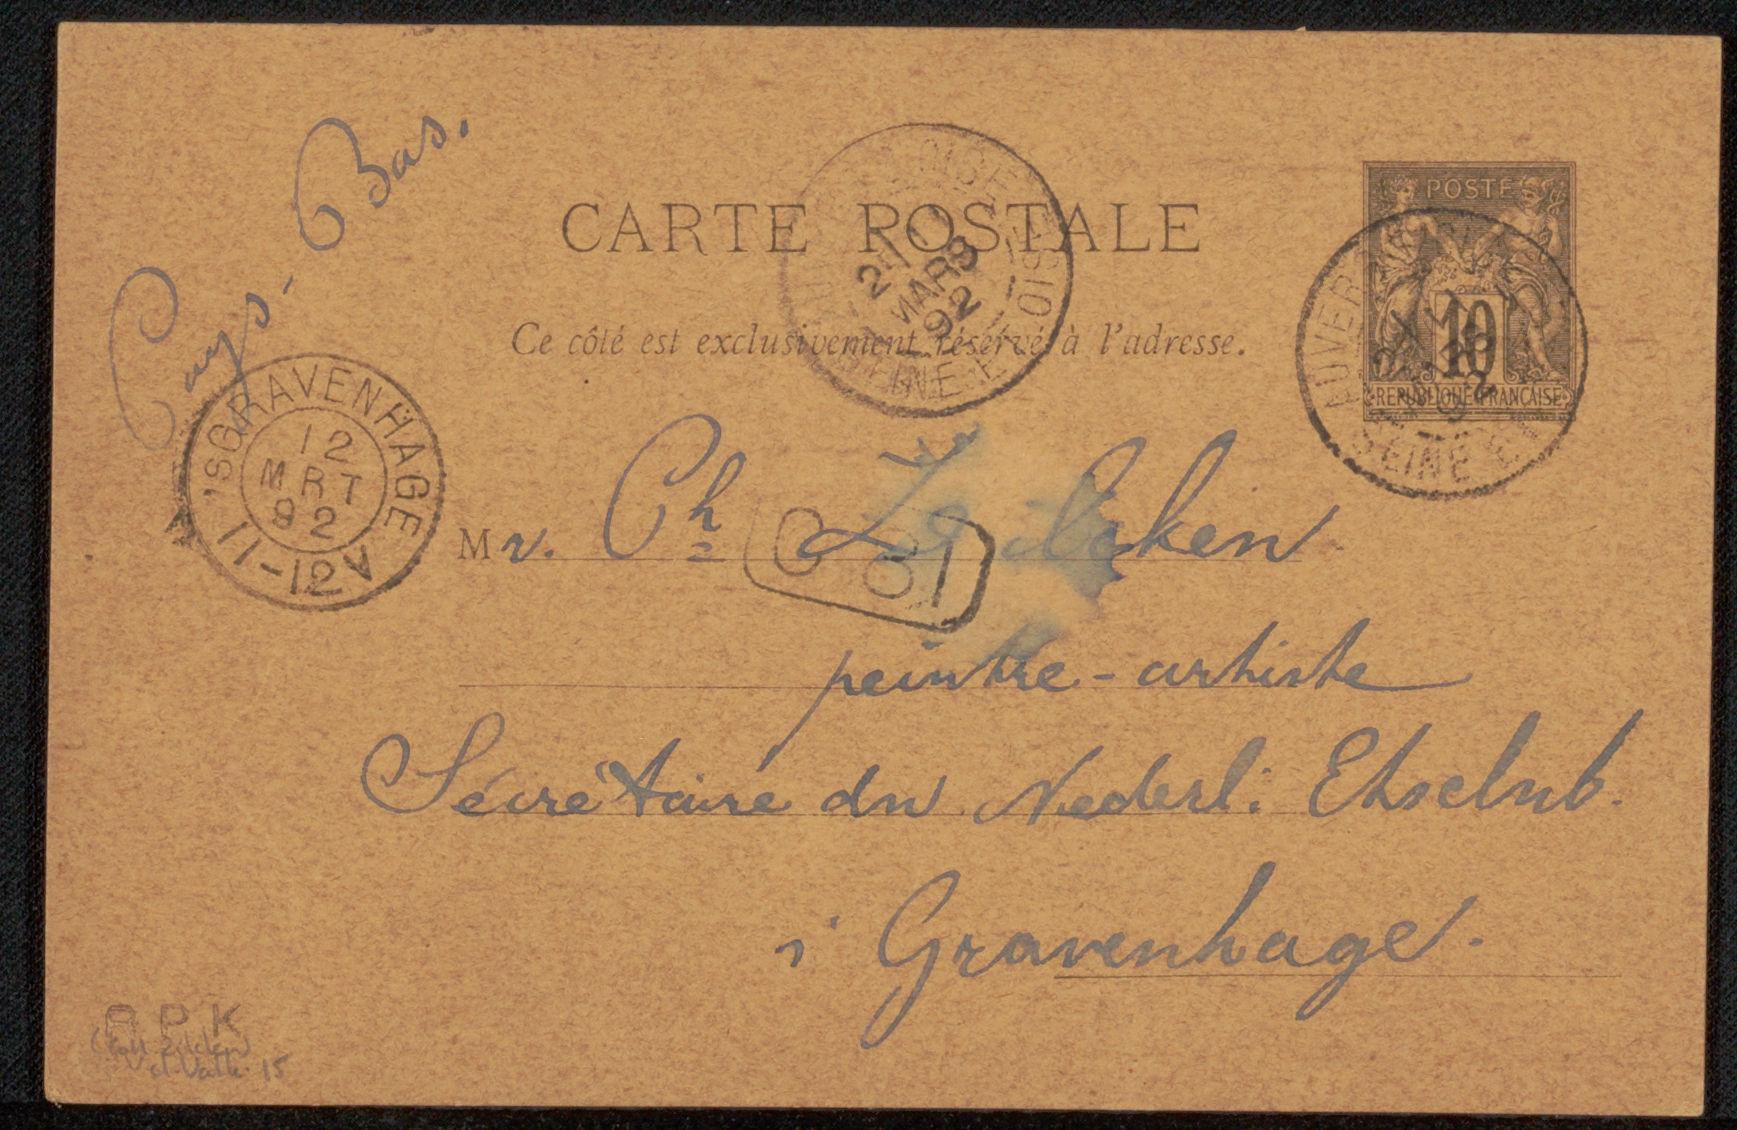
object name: postcard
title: Briefkaart aan Philip Zilcken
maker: maurits van der valk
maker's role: draughtsman, print maker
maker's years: 1857-1935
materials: cardboard, ink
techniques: pen, writing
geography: auvers-sur-oise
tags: the hague, painter, philip zilcken, paris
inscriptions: collector's mark: ‘RPK’